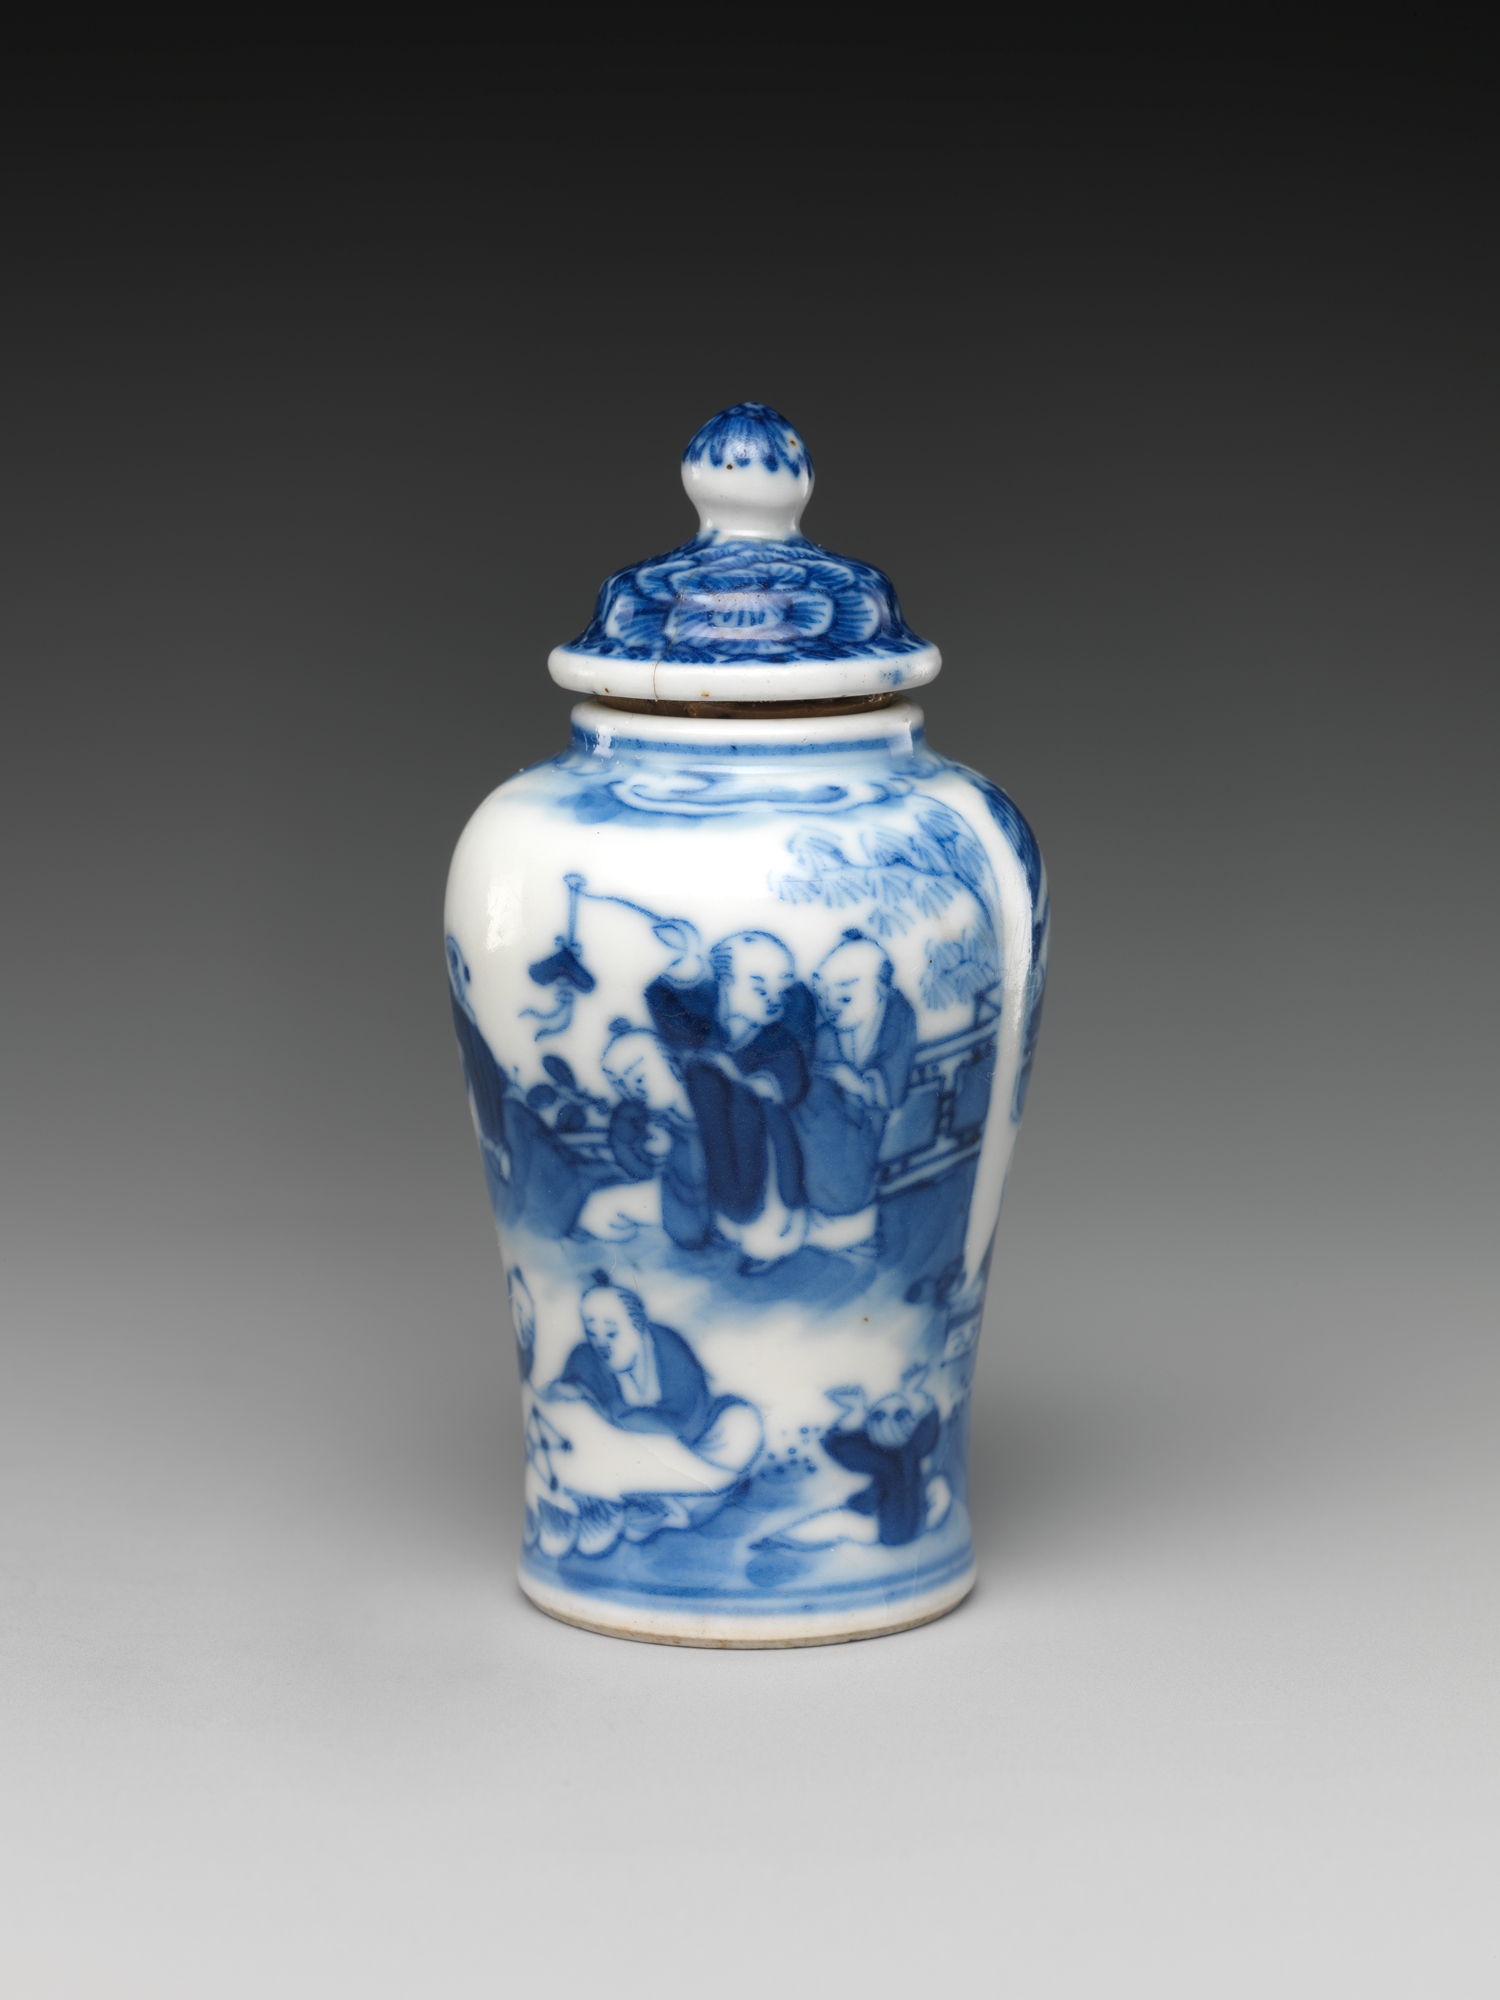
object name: snuff bottle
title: Snuff bottle with boys at play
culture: chinese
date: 1801-1900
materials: cobalt, porcelain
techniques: painting, underglaze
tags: boys